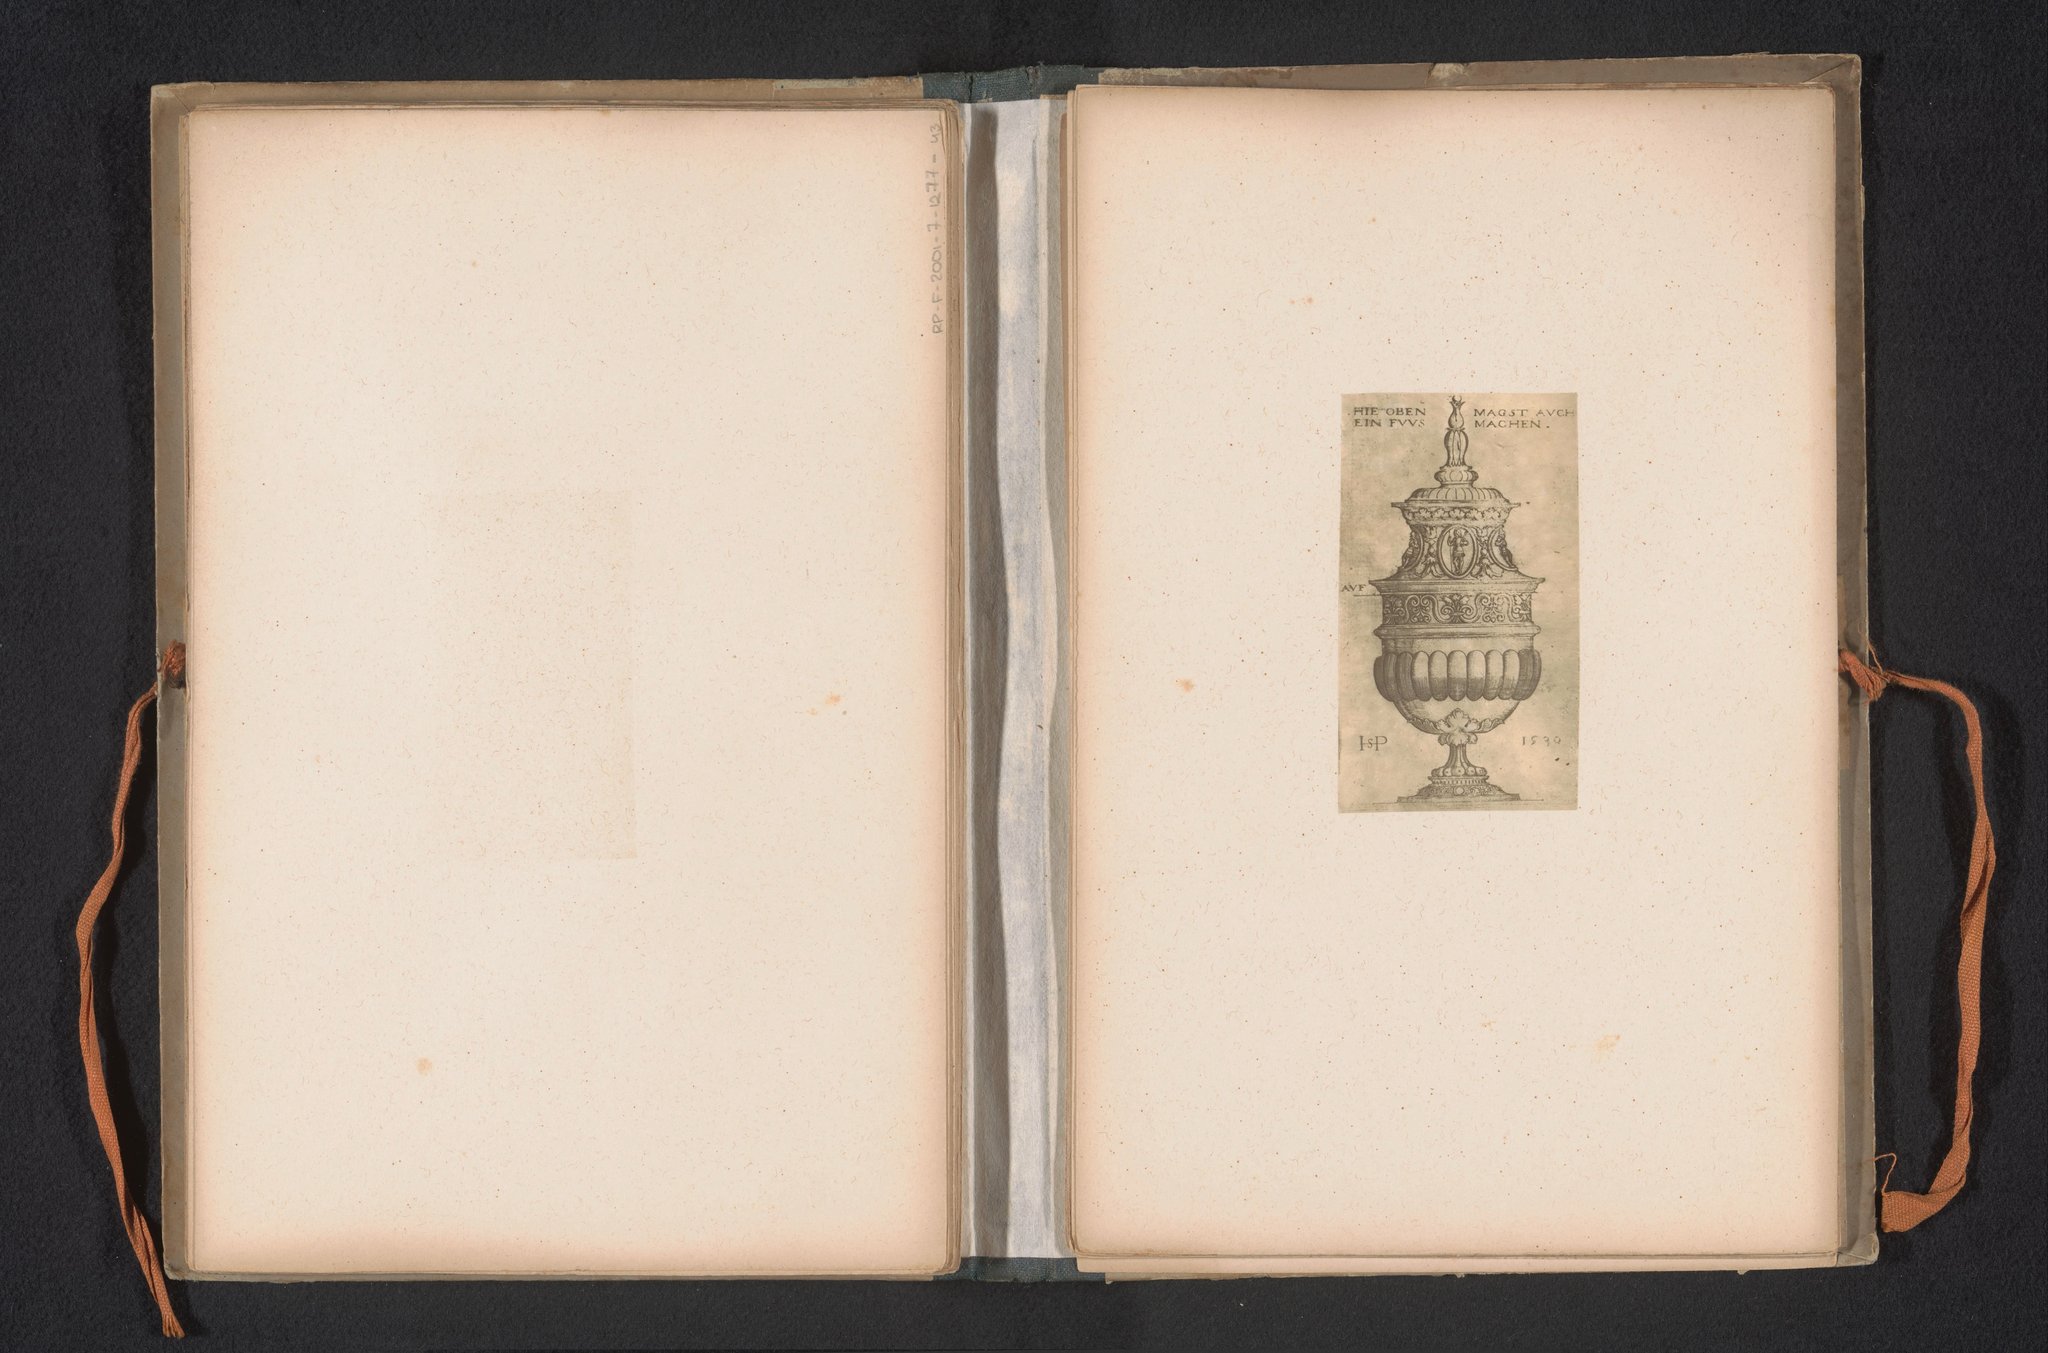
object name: photomechanical print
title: Reproductie van een prent van een bokaal met deksel door Hans Sebald Beham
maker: hans sebald beham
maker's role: designer, draughtsman, print maker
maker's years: 1500-1550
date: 1866-1871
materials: paper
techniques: woodburytype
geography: brussels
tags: mug, beaker, goblet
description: Deze prent maakt deel uit van een omslag met 57 prenten op 54 bladen.